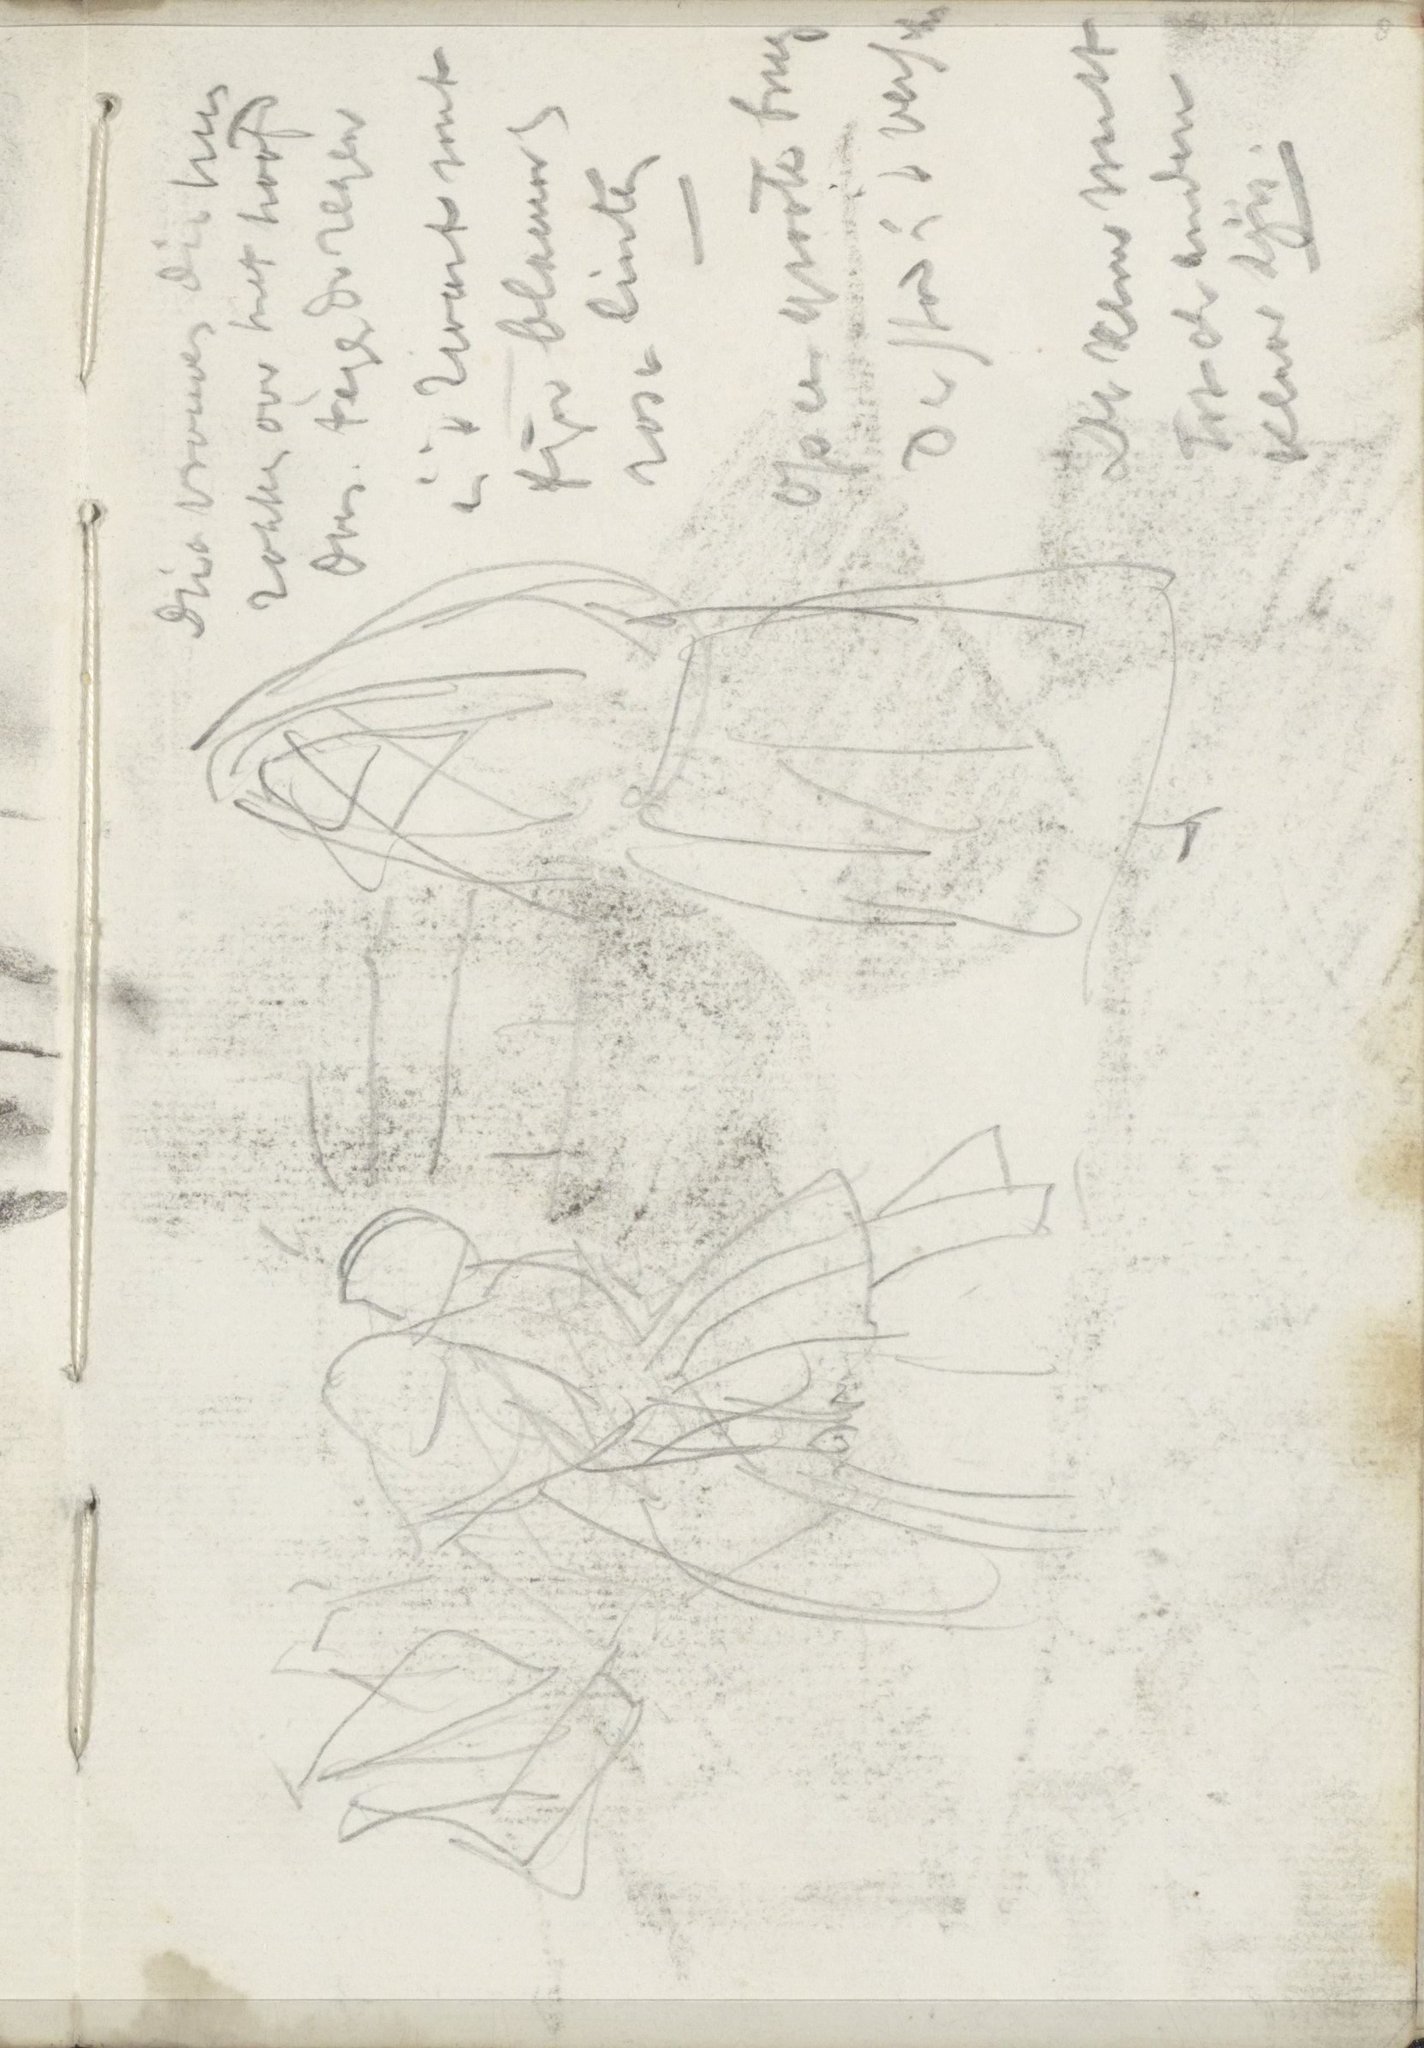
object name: sketchbook leaf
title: Drie vrouwen in de regen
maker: george hendrik breitner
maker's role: draughtsman, painter, print maker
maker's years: 1857-1923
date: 1886-1898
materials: paper, pencil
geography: amsterdam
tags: rain, adult woman (+ three persons), amsterdam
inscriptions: annotation: ‘Drie vrouwen die hun/ rokken over het hoofd/ doen tegen de regen/ [kleurnotities]/ op een groote brug/ de stad in 't verschiet/ De [...] wacht/ tot de anderen/ klaar zijn.’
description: Pagina 8 uit een schetsboek met 21 bladen.